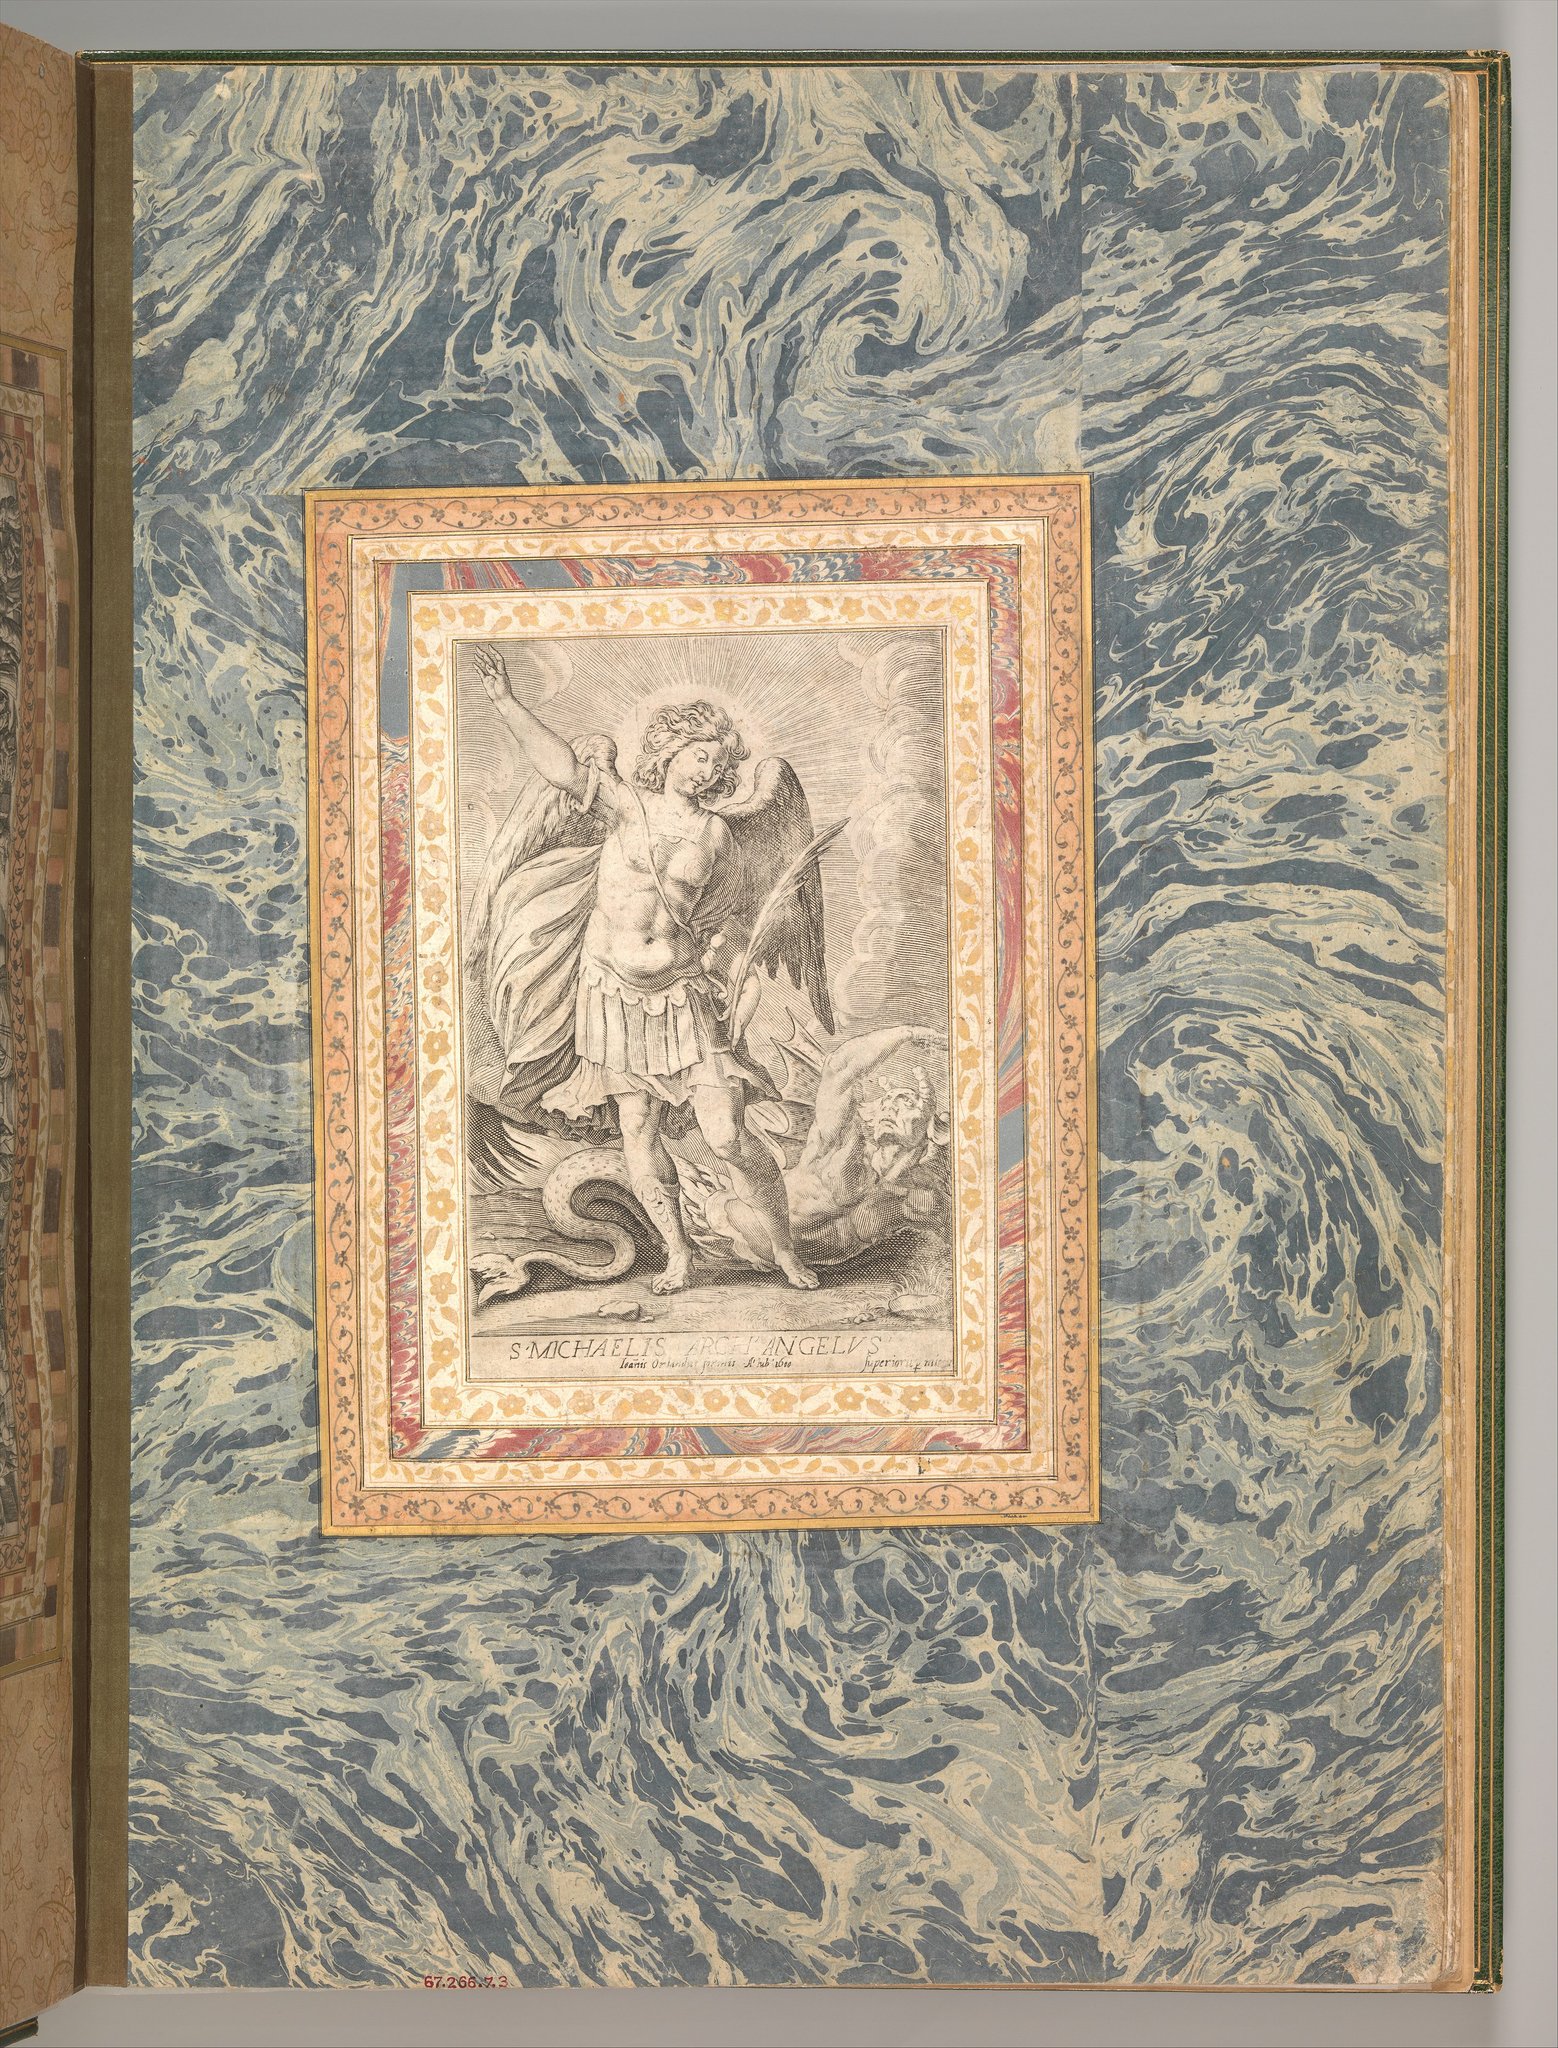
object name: illustrated album leaf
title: "St. Michael, the Archangel," Folio from the Bellini Album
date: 1600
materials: gold, ink, paper, watercolor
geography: italy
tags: mythical creatures,angels